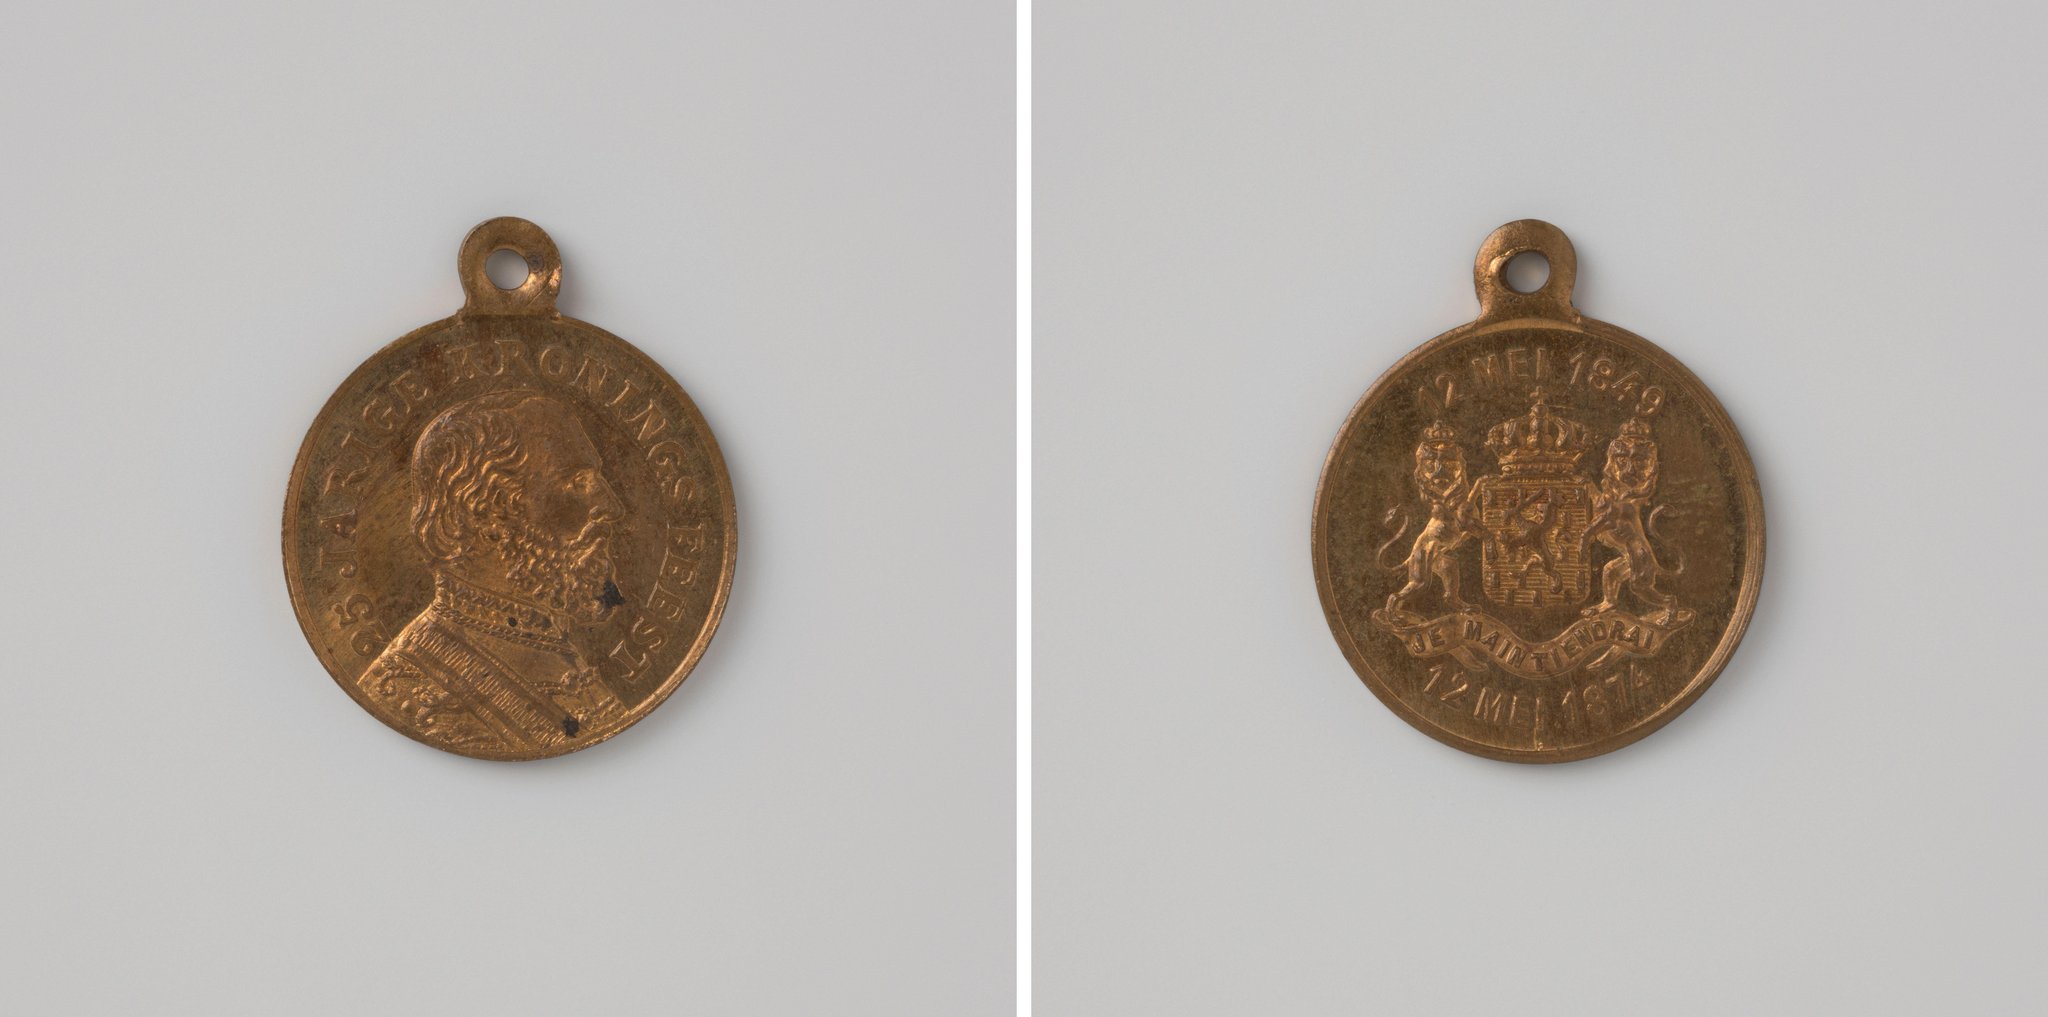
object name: history medal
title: Vijfentwintigjarig regeringsjubileum van Koning Willem III 1874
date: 1874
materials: brass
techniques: striking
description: Klein messing penninkje met draagoog, op de voorzijde het geuniformeerde borstbeeld van Willem naar rechts met omschrift, op de keerzijde het gekroonde Nederlandse wapenschild dragers, met onder en boven tekst.